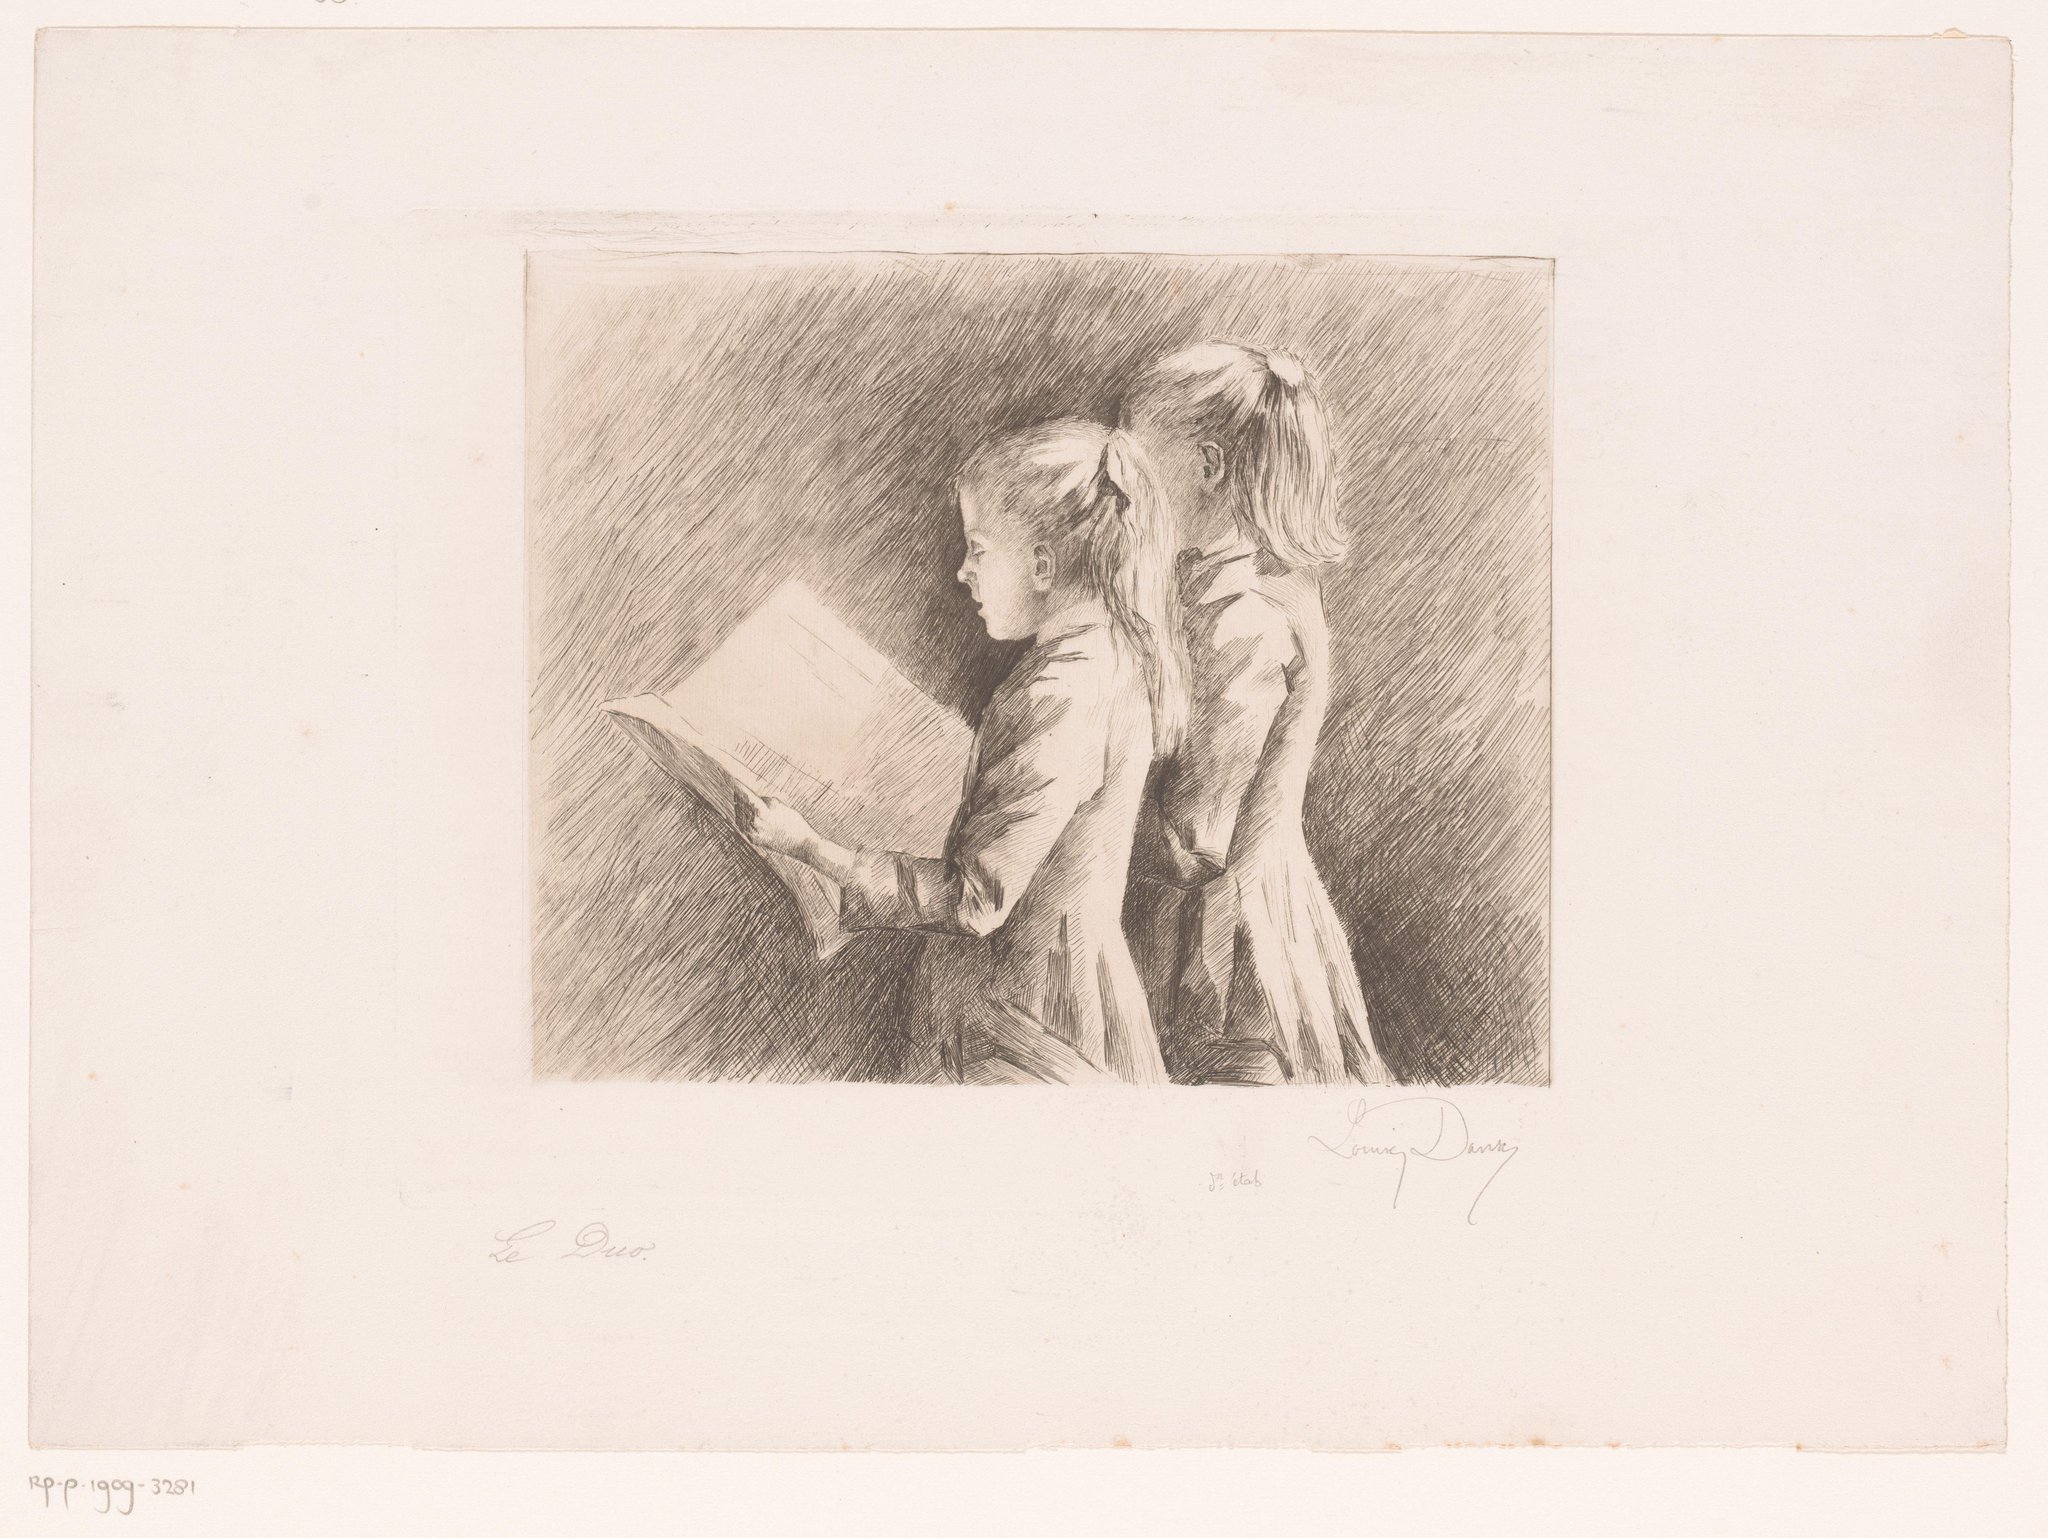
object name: print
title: Twee meisjes zingen van bladmuziek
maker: louise danse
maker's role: painter, print maker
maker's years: 1867-1948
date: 1877-1909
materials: paper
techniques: etching, intaglio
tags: children singing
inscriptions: collector's mark: Lugt 2228, annotation: ‘Dn état’